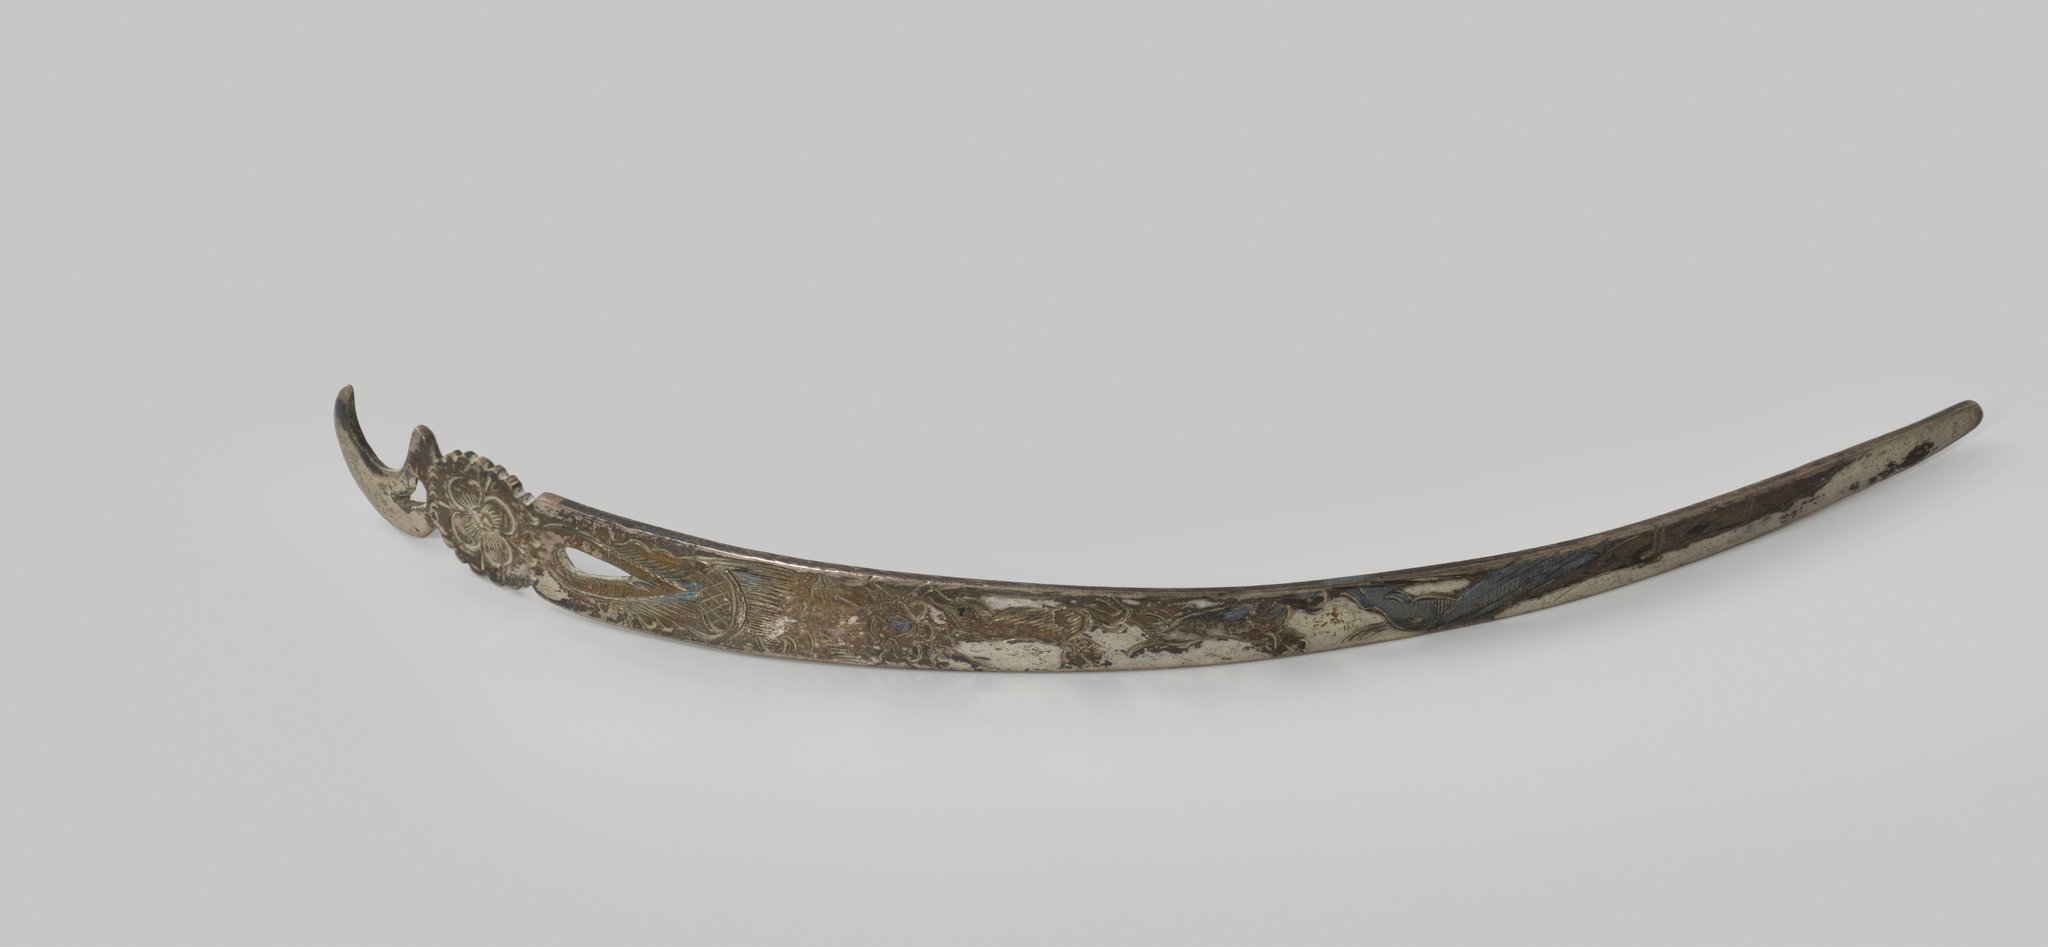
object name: kapnaald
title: Haar- of kapnaald van zilver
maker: Anonymous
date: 1700-1800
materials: silver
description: Een zilveren haar- of kapnaald, met aan het einde een halve maan. Gegraveerd met een voorstelling van twee honden die een haas in een net jagen.